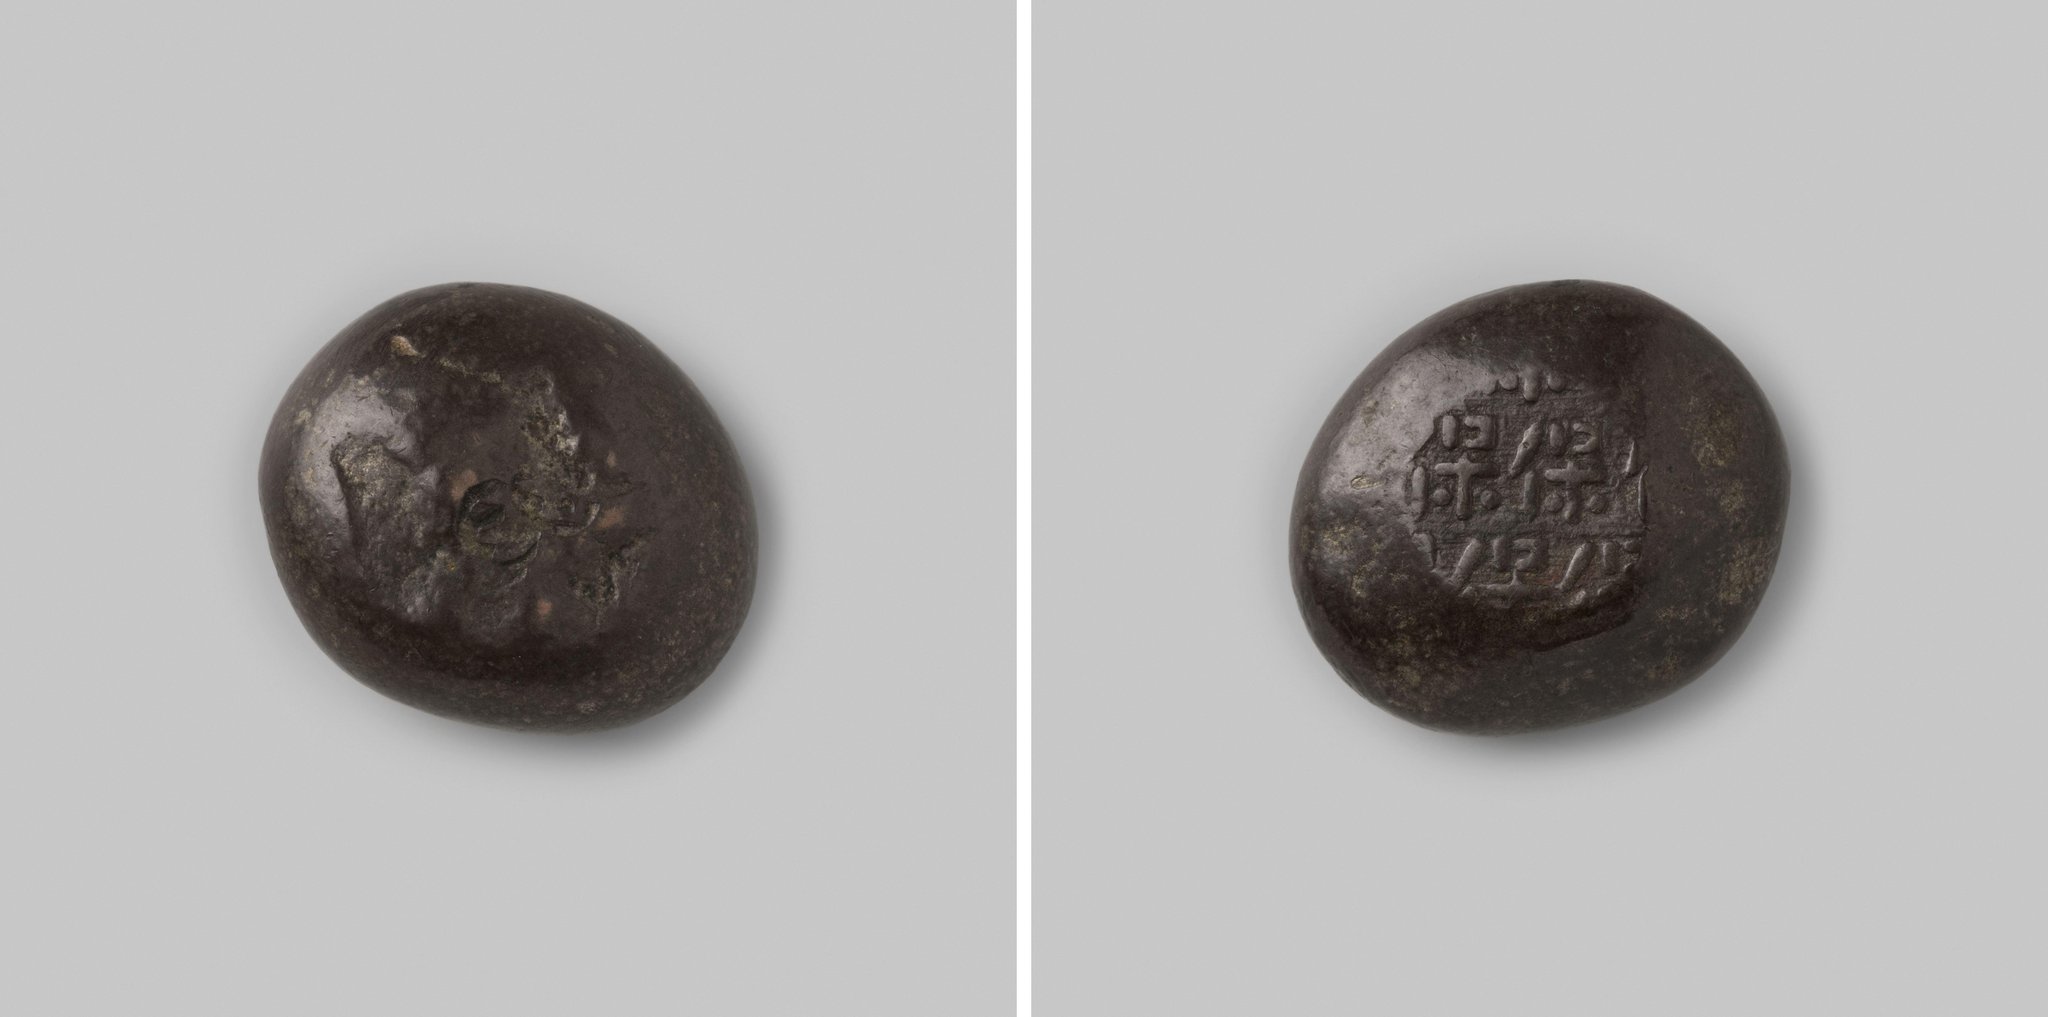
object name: coin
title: Mametita-gin [=zilveren boontje] van 2 bu van het keizerrijk Japan, uit de 17e, 18e en 19e eeuw tot 1865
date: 1600-1865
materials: silver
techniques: striking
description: Zilveren langwerpige munt. Voorzijde: deel van een formele inscriptie met tijdperk-aanduiding: Of: "God van de Veelvuldigheid-symbool met op zijn buik tijdperk-aanduiding. Keerzijde: Japanse karakters.